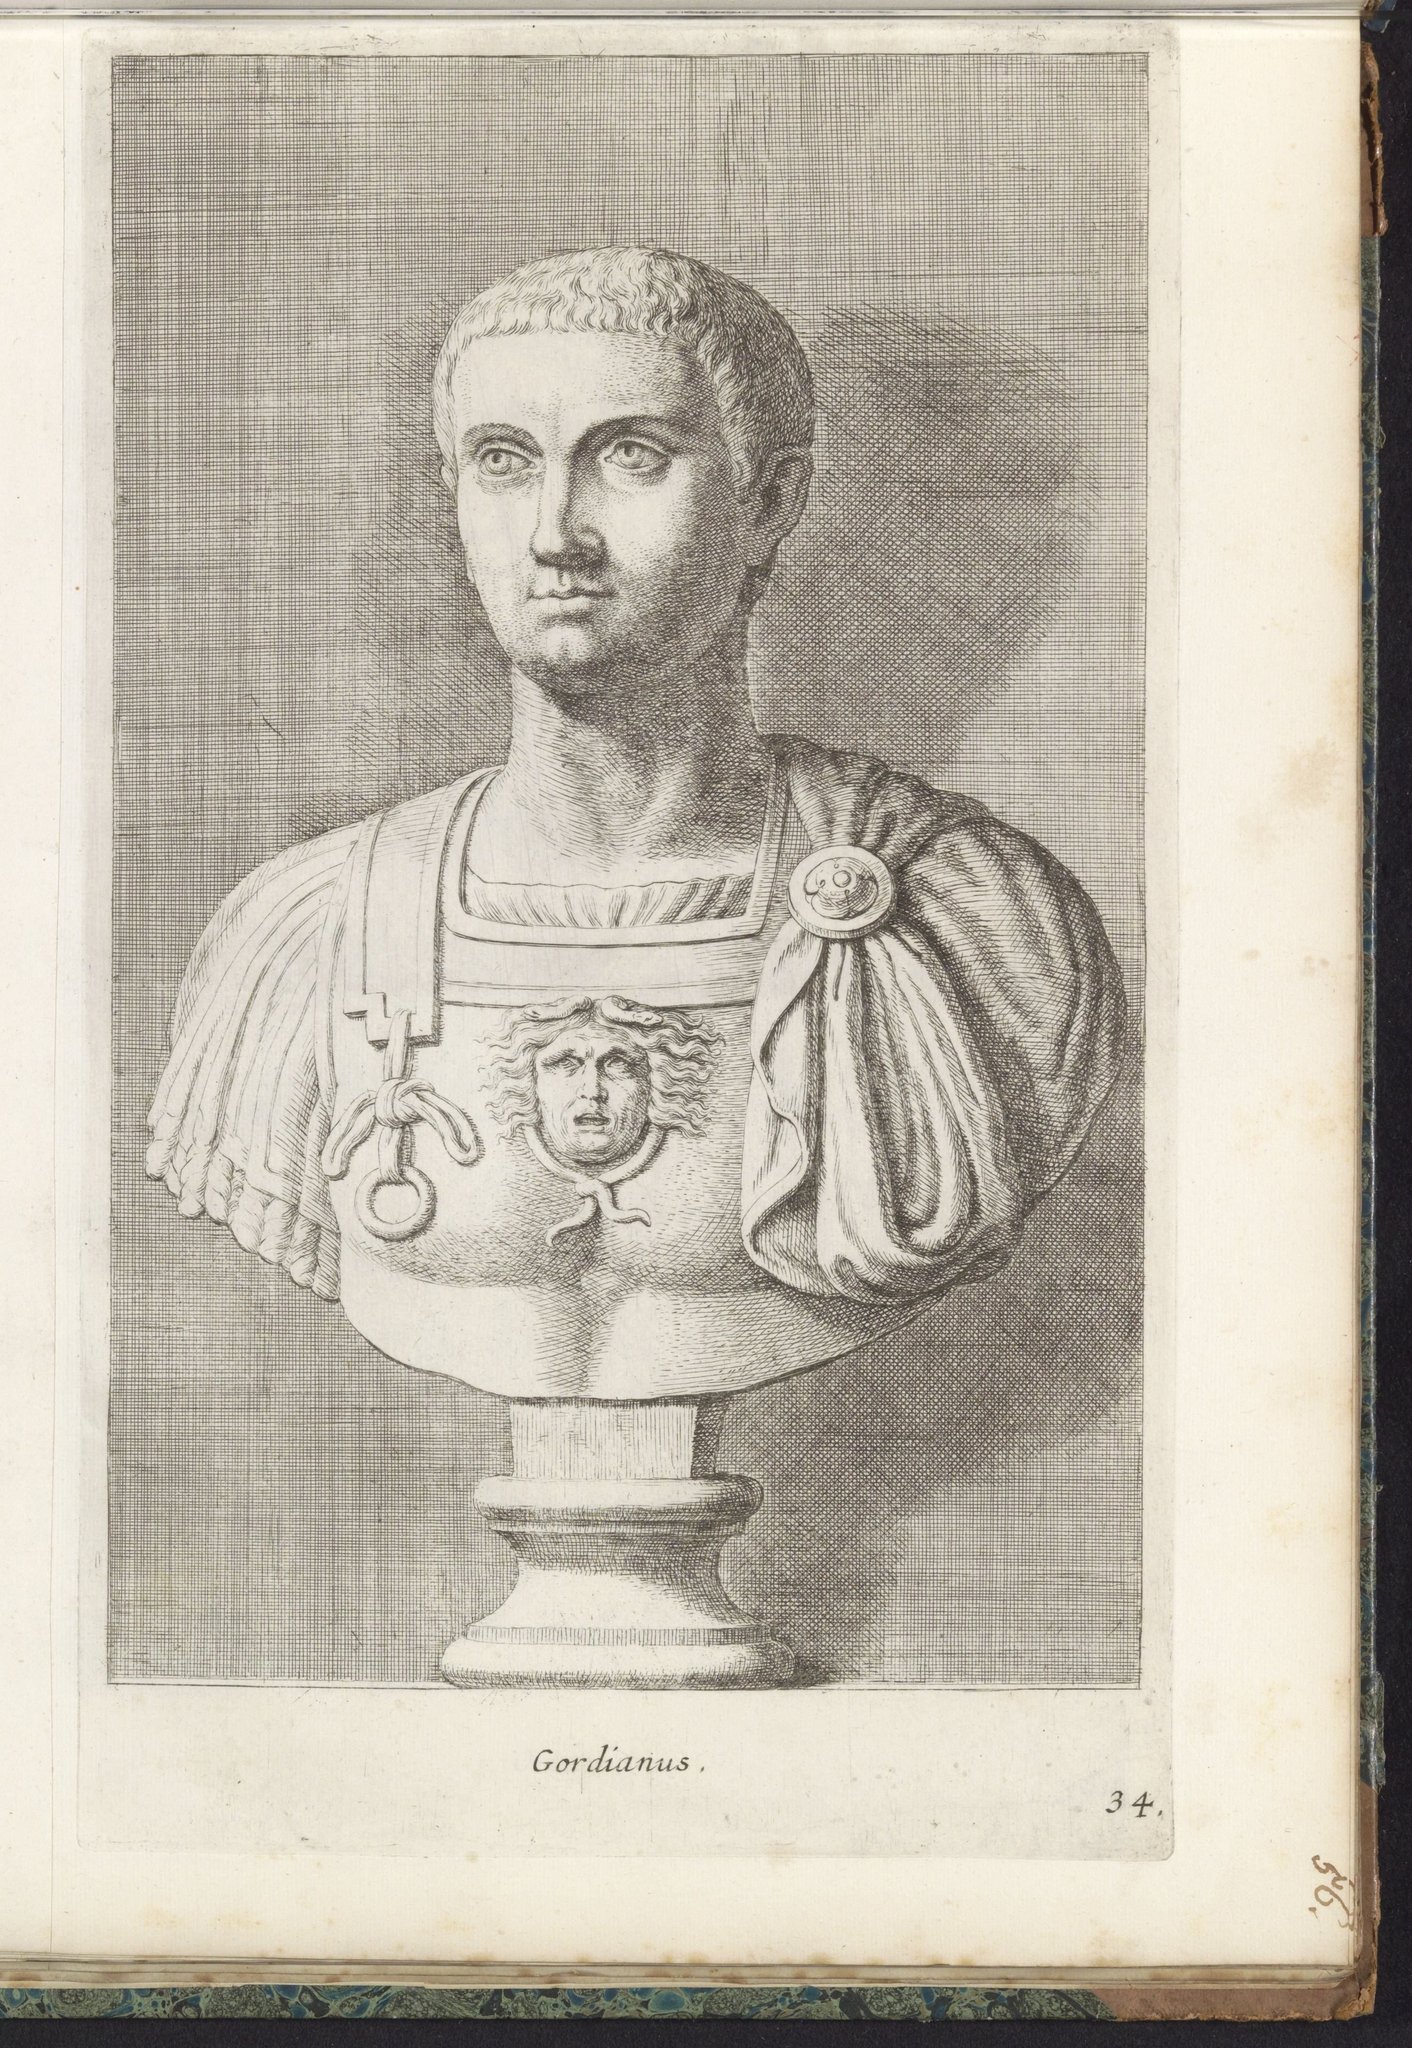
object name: print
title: Gordianus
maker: hubert quellinus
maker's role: print maker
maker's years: 1619-1687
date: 1646-1670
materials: paper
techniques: engraving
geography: antwerp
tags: piece of sculpture, reproduction of a piece of sculpture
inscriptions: number: ‘56’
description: Klassieke buste van een man. Hij draagt een borstharnas met het hoofd van Medusa. De prent maakt deel uit van een album met een serie prenten naar de sculpturen in de verzameling van Gerard Reynst.